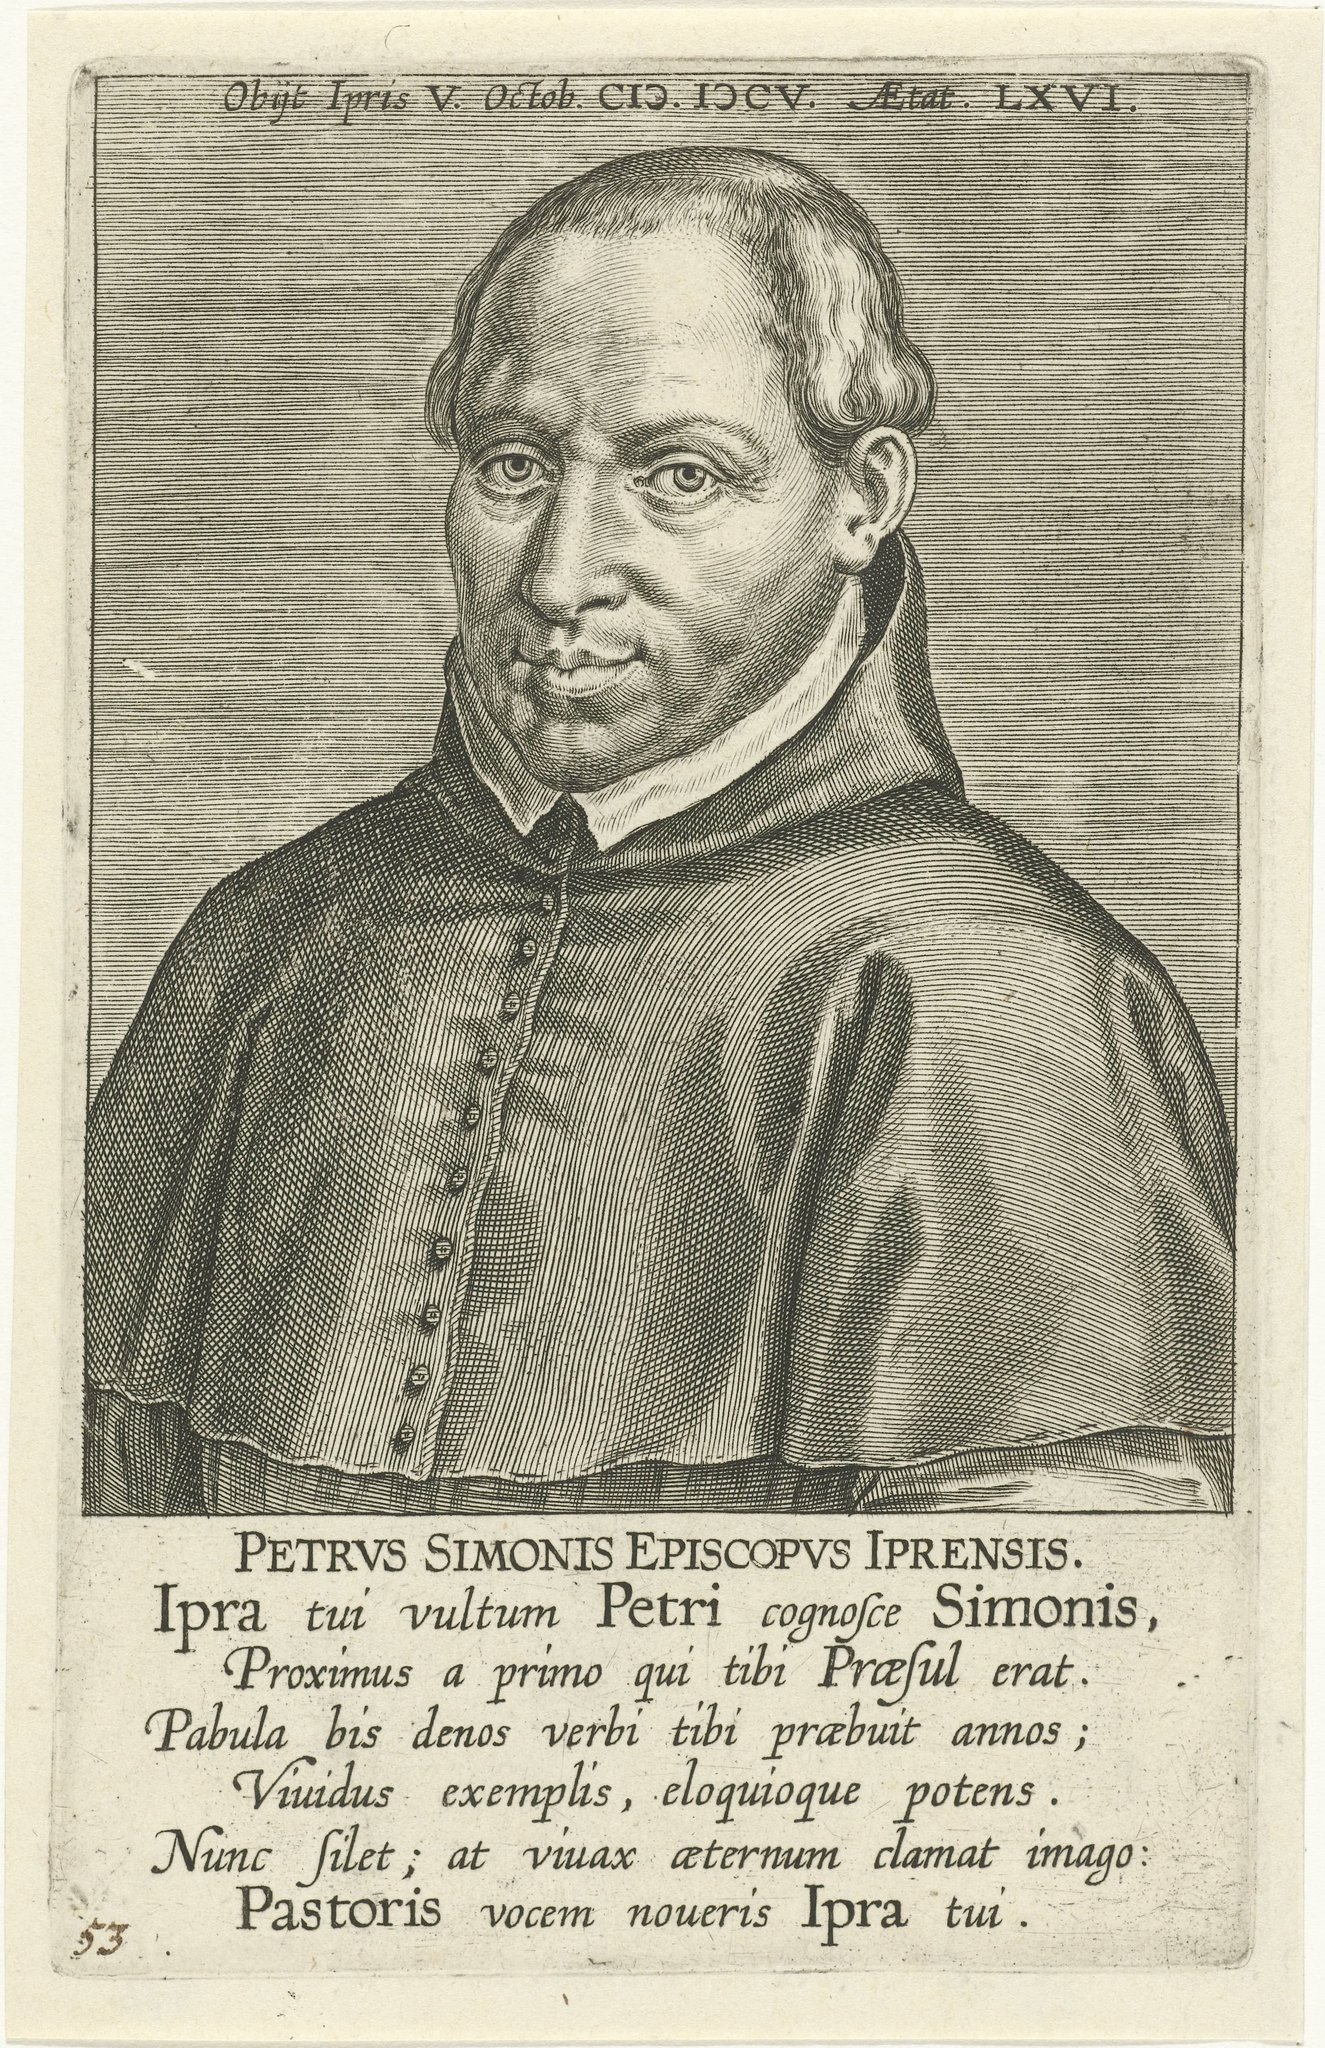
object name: book illustration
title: Bekende schrijvers uit de Nederlanden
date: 1608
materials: paper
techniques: engraving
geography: antwerp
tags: tielt, ieper (stad), bisschop, petrus simons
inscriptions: collector's mark: Lugt 2228, number: ‘53’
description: Portret van Petrus Simons, bisschop van Ieper. Buste naar links. De prent heeft een Latijns boven- en onderschrift en maakt deel uit van een serie van bekende schrijvers uit de Nederlanden.